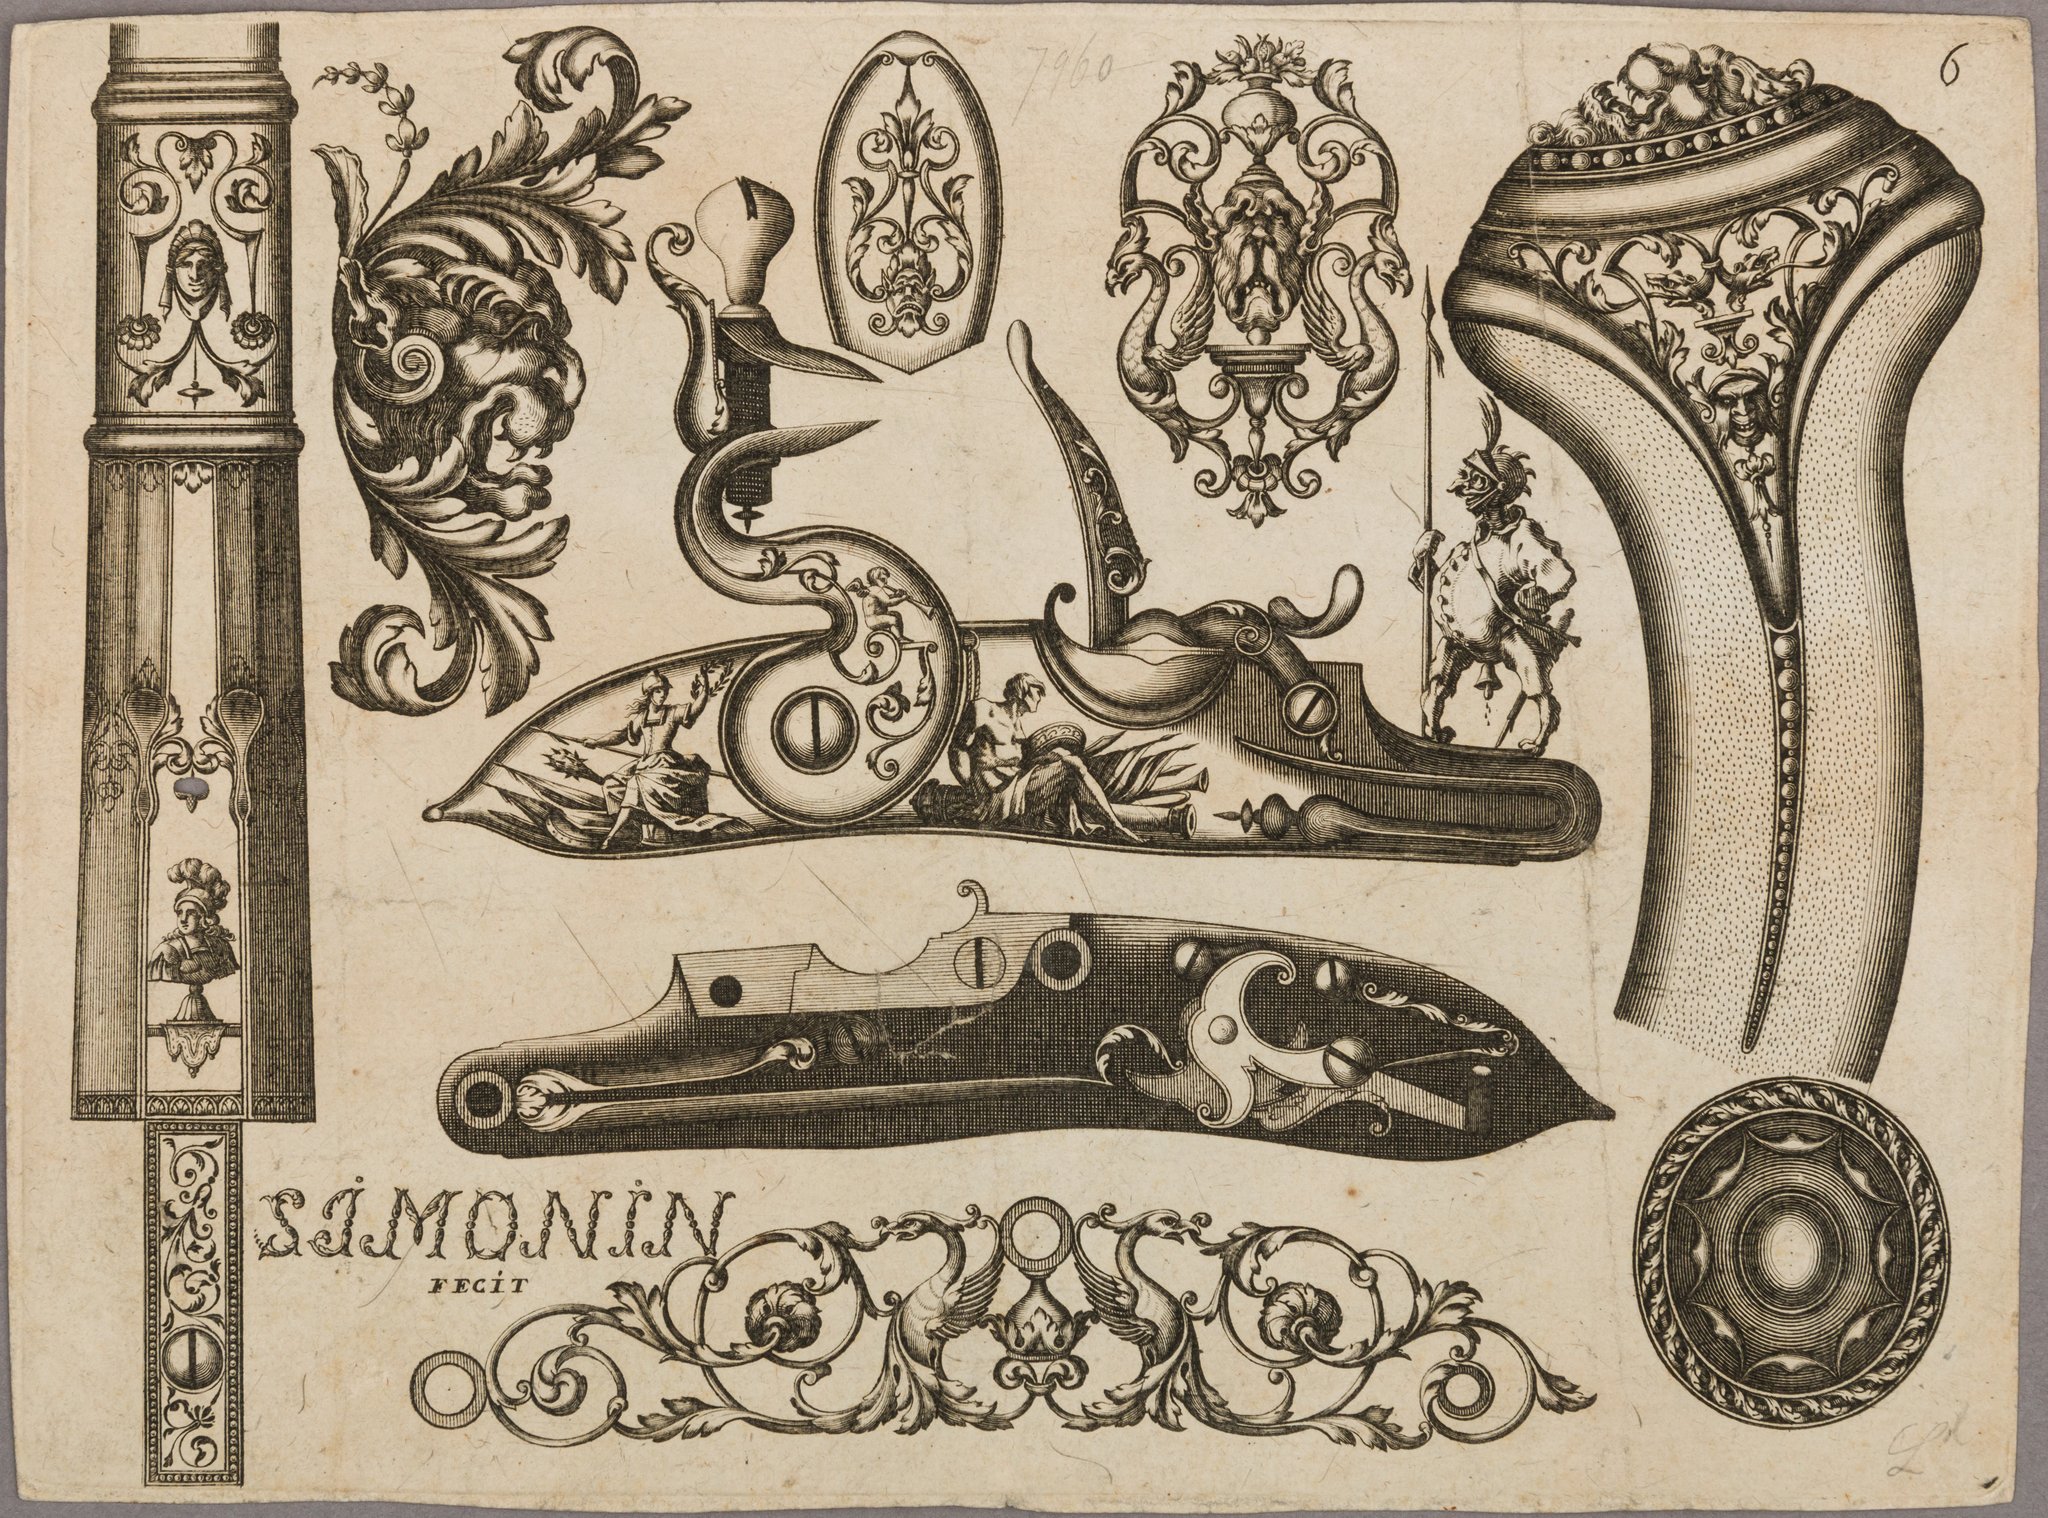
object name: engraving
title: Engraving of Firearms Ornament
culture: french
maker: claude simonin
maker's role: artist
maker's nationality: french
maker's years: 1635-1693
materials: ink, paper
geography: france